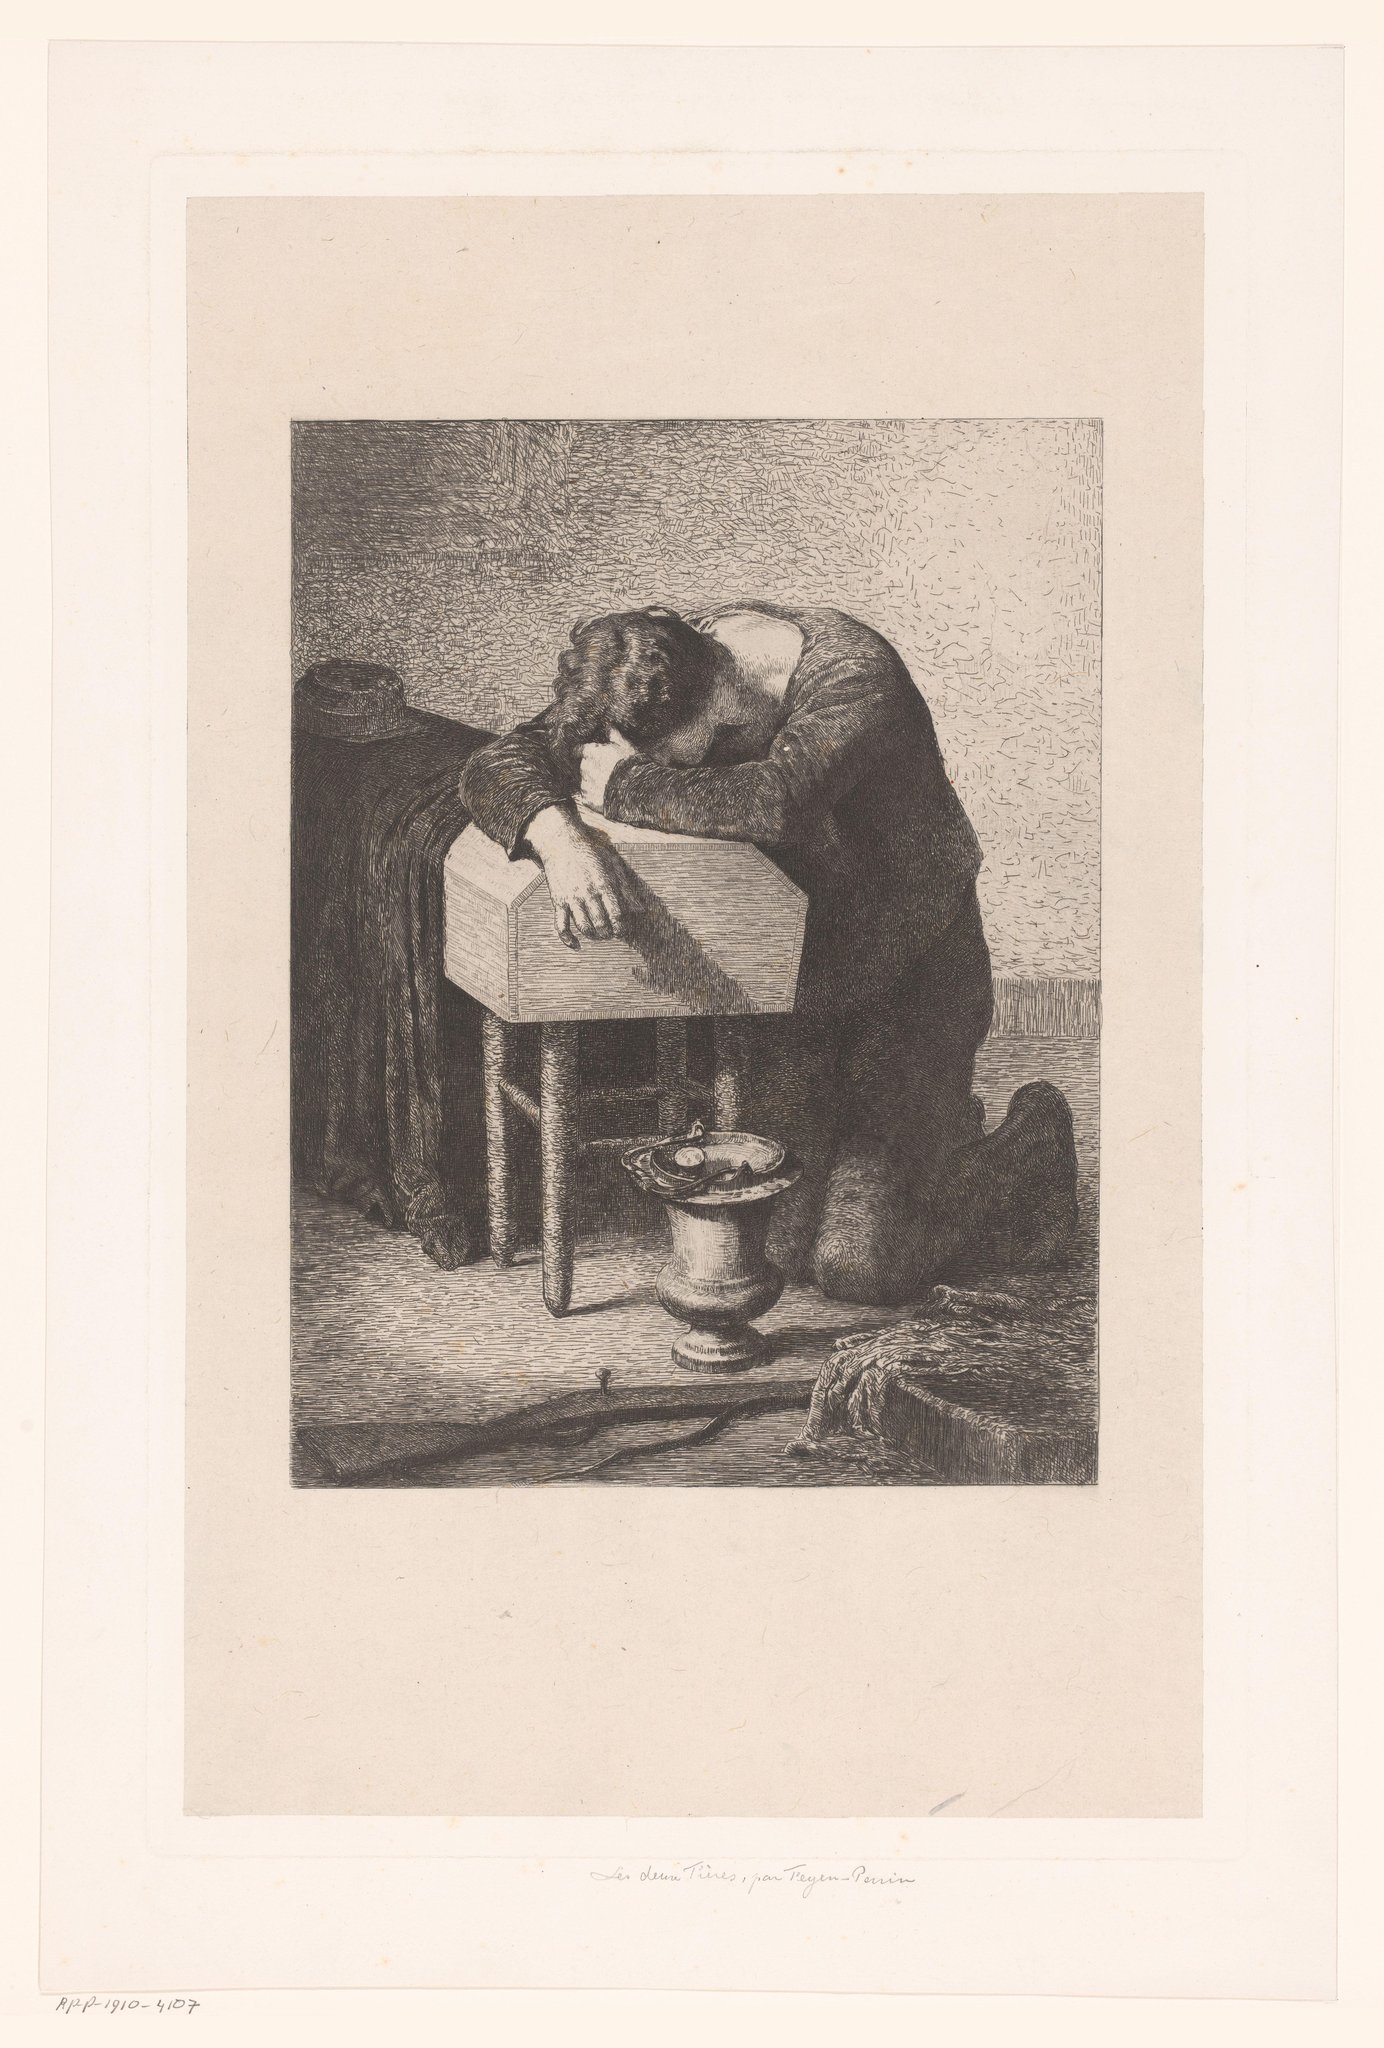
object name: print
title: Bewening van een doodskist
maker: françois-nicolas-augustin feyen-perrin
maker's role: print maker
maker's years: 1826-1888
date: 1836-1888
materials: paper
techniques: drypoint, etching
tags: coffin, pain, sorrow, sadness; 'dolore', 'dolore di zeusi' (ripa)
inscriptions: collector's mark: Lugt 2228